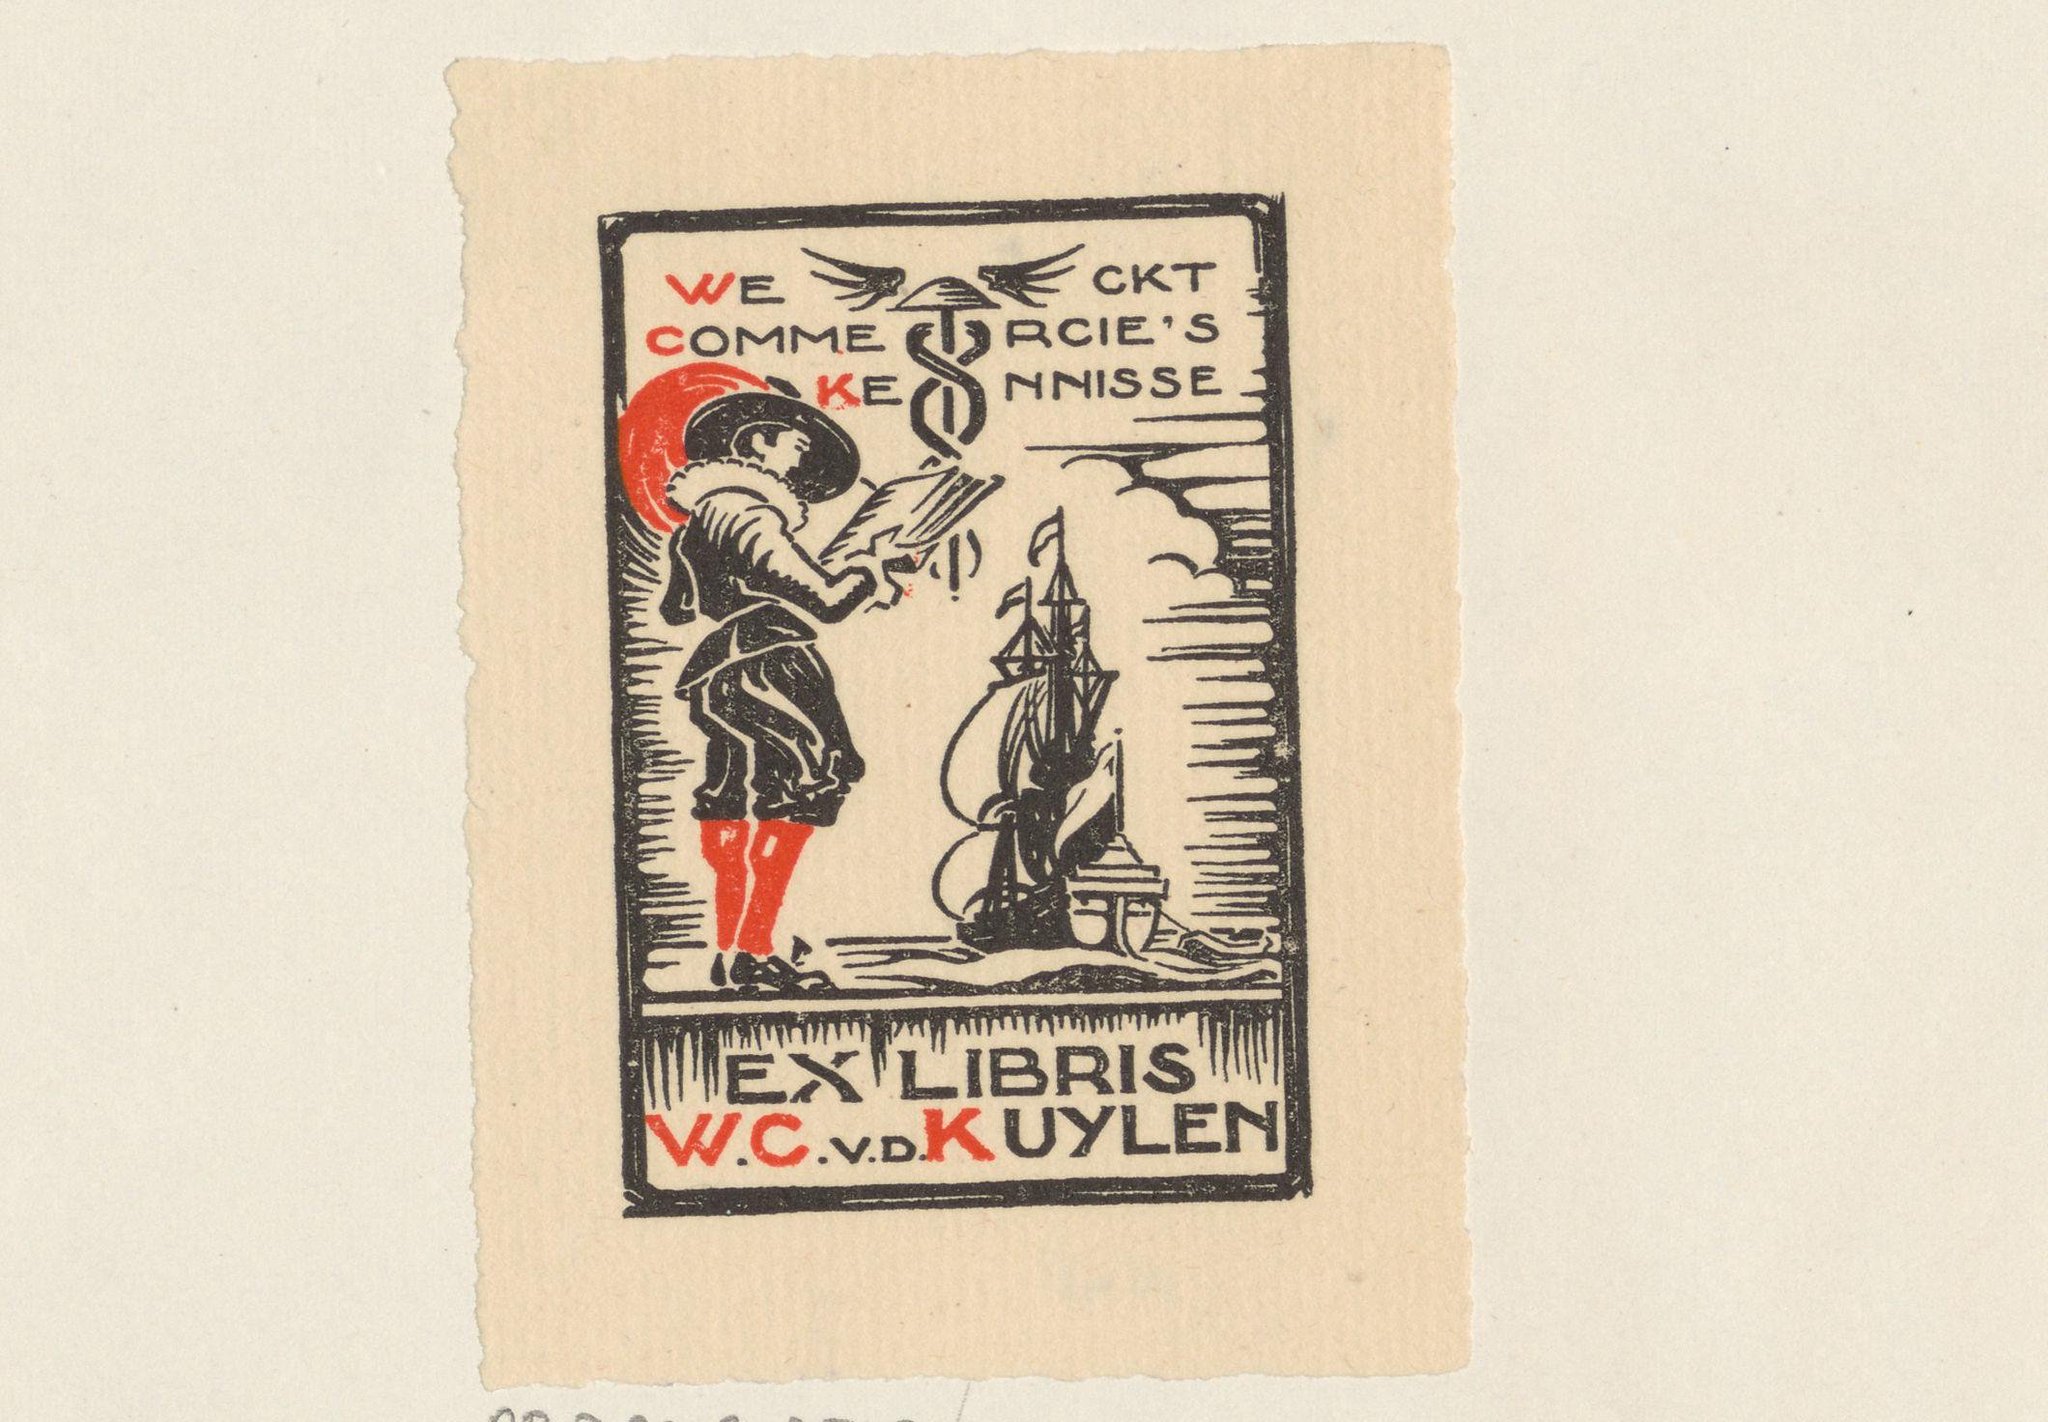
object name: bookplate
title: Ex libris van W.C. v.d. Kuylen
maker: Anonymous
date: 1850-1950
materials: paper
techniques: printing block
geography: netherlands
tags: historical costume, caduceus (staff with two snakes, attribute of mercury), merchant shipping, shipping trade, trade, commerce and finance